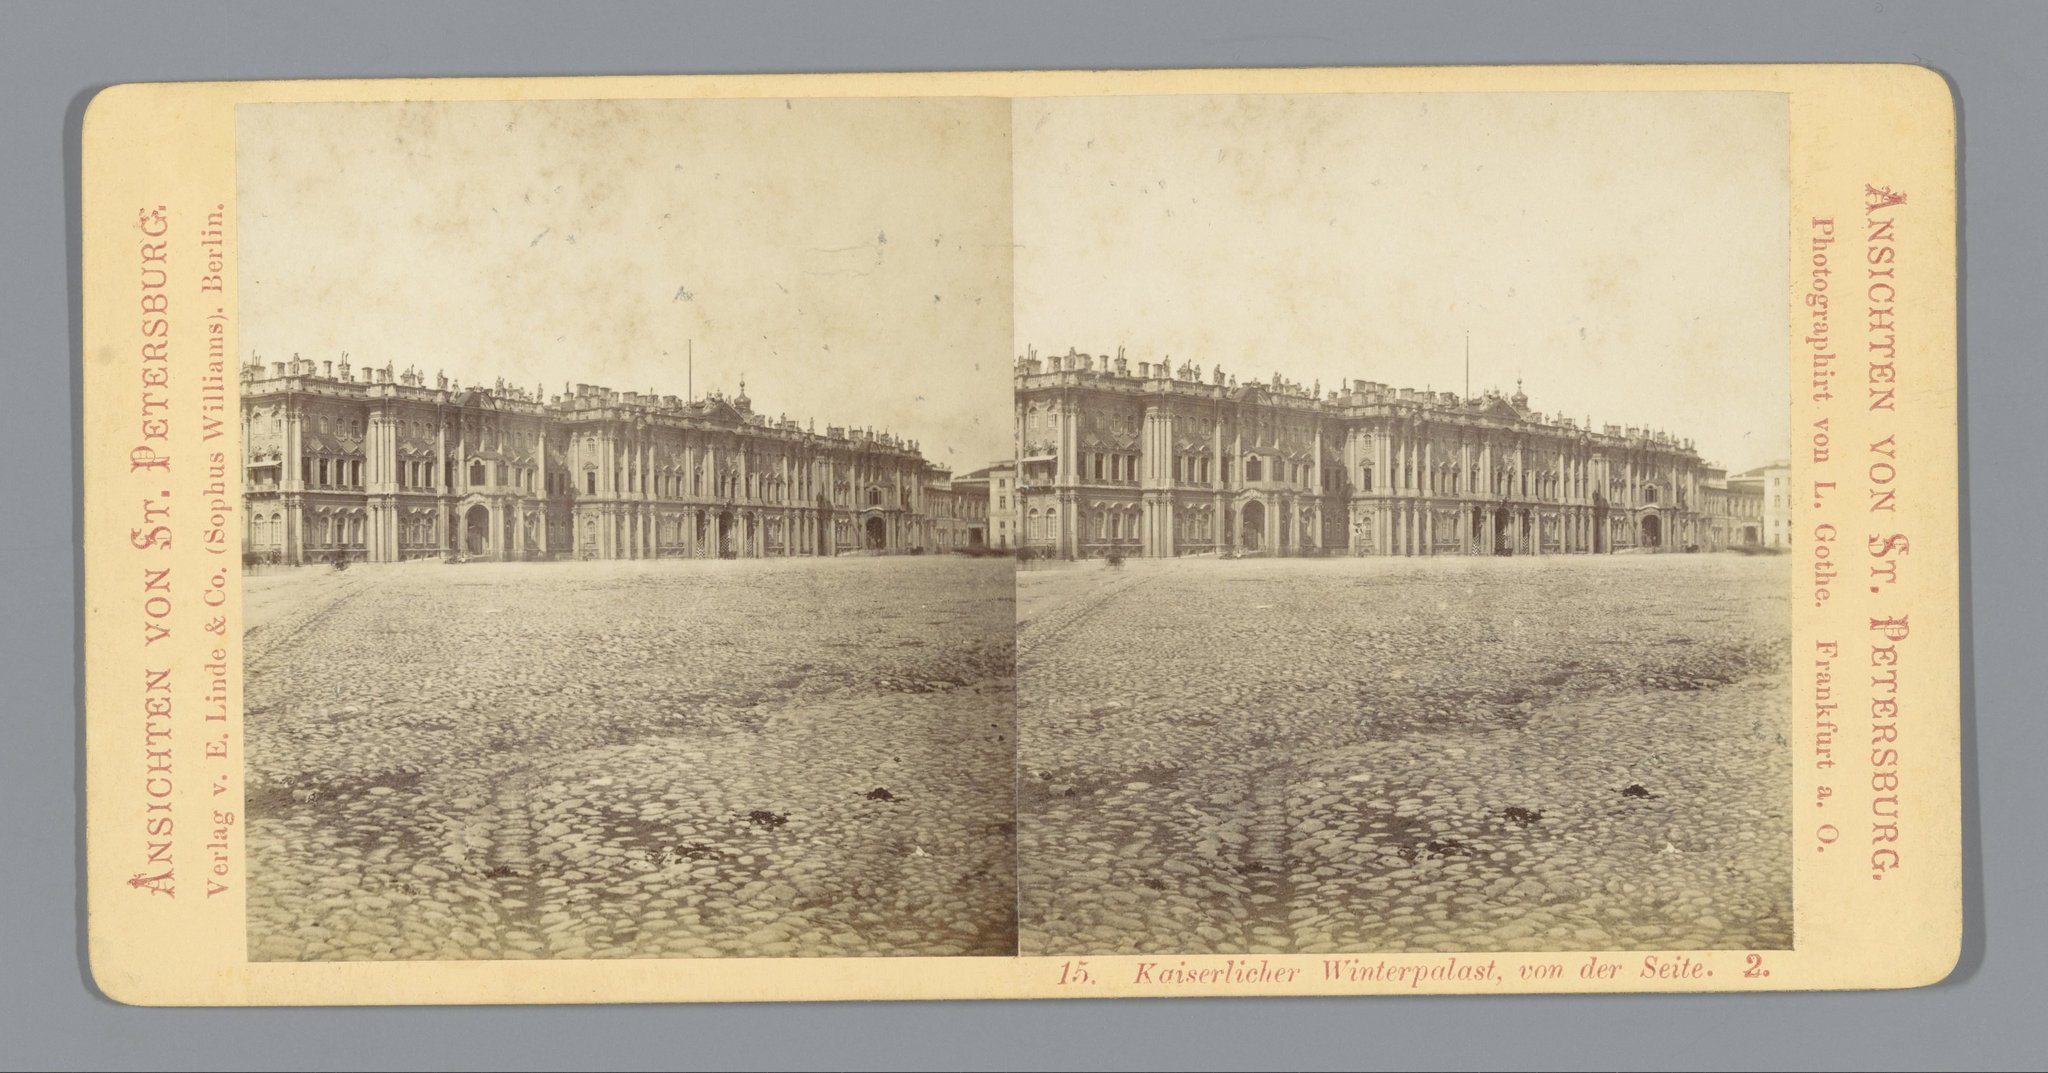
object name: stereograph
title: Kaiserlicher Winterpalast, von der Seite. 2.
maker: louis gothe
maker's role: fotograaf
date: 1850-1880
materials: cardboard, photographic support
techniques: albumen print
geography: sint-petersburg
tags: palace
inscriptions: number: ‘15.’, inscription: ‘Ansichten von St. Petersburg.’